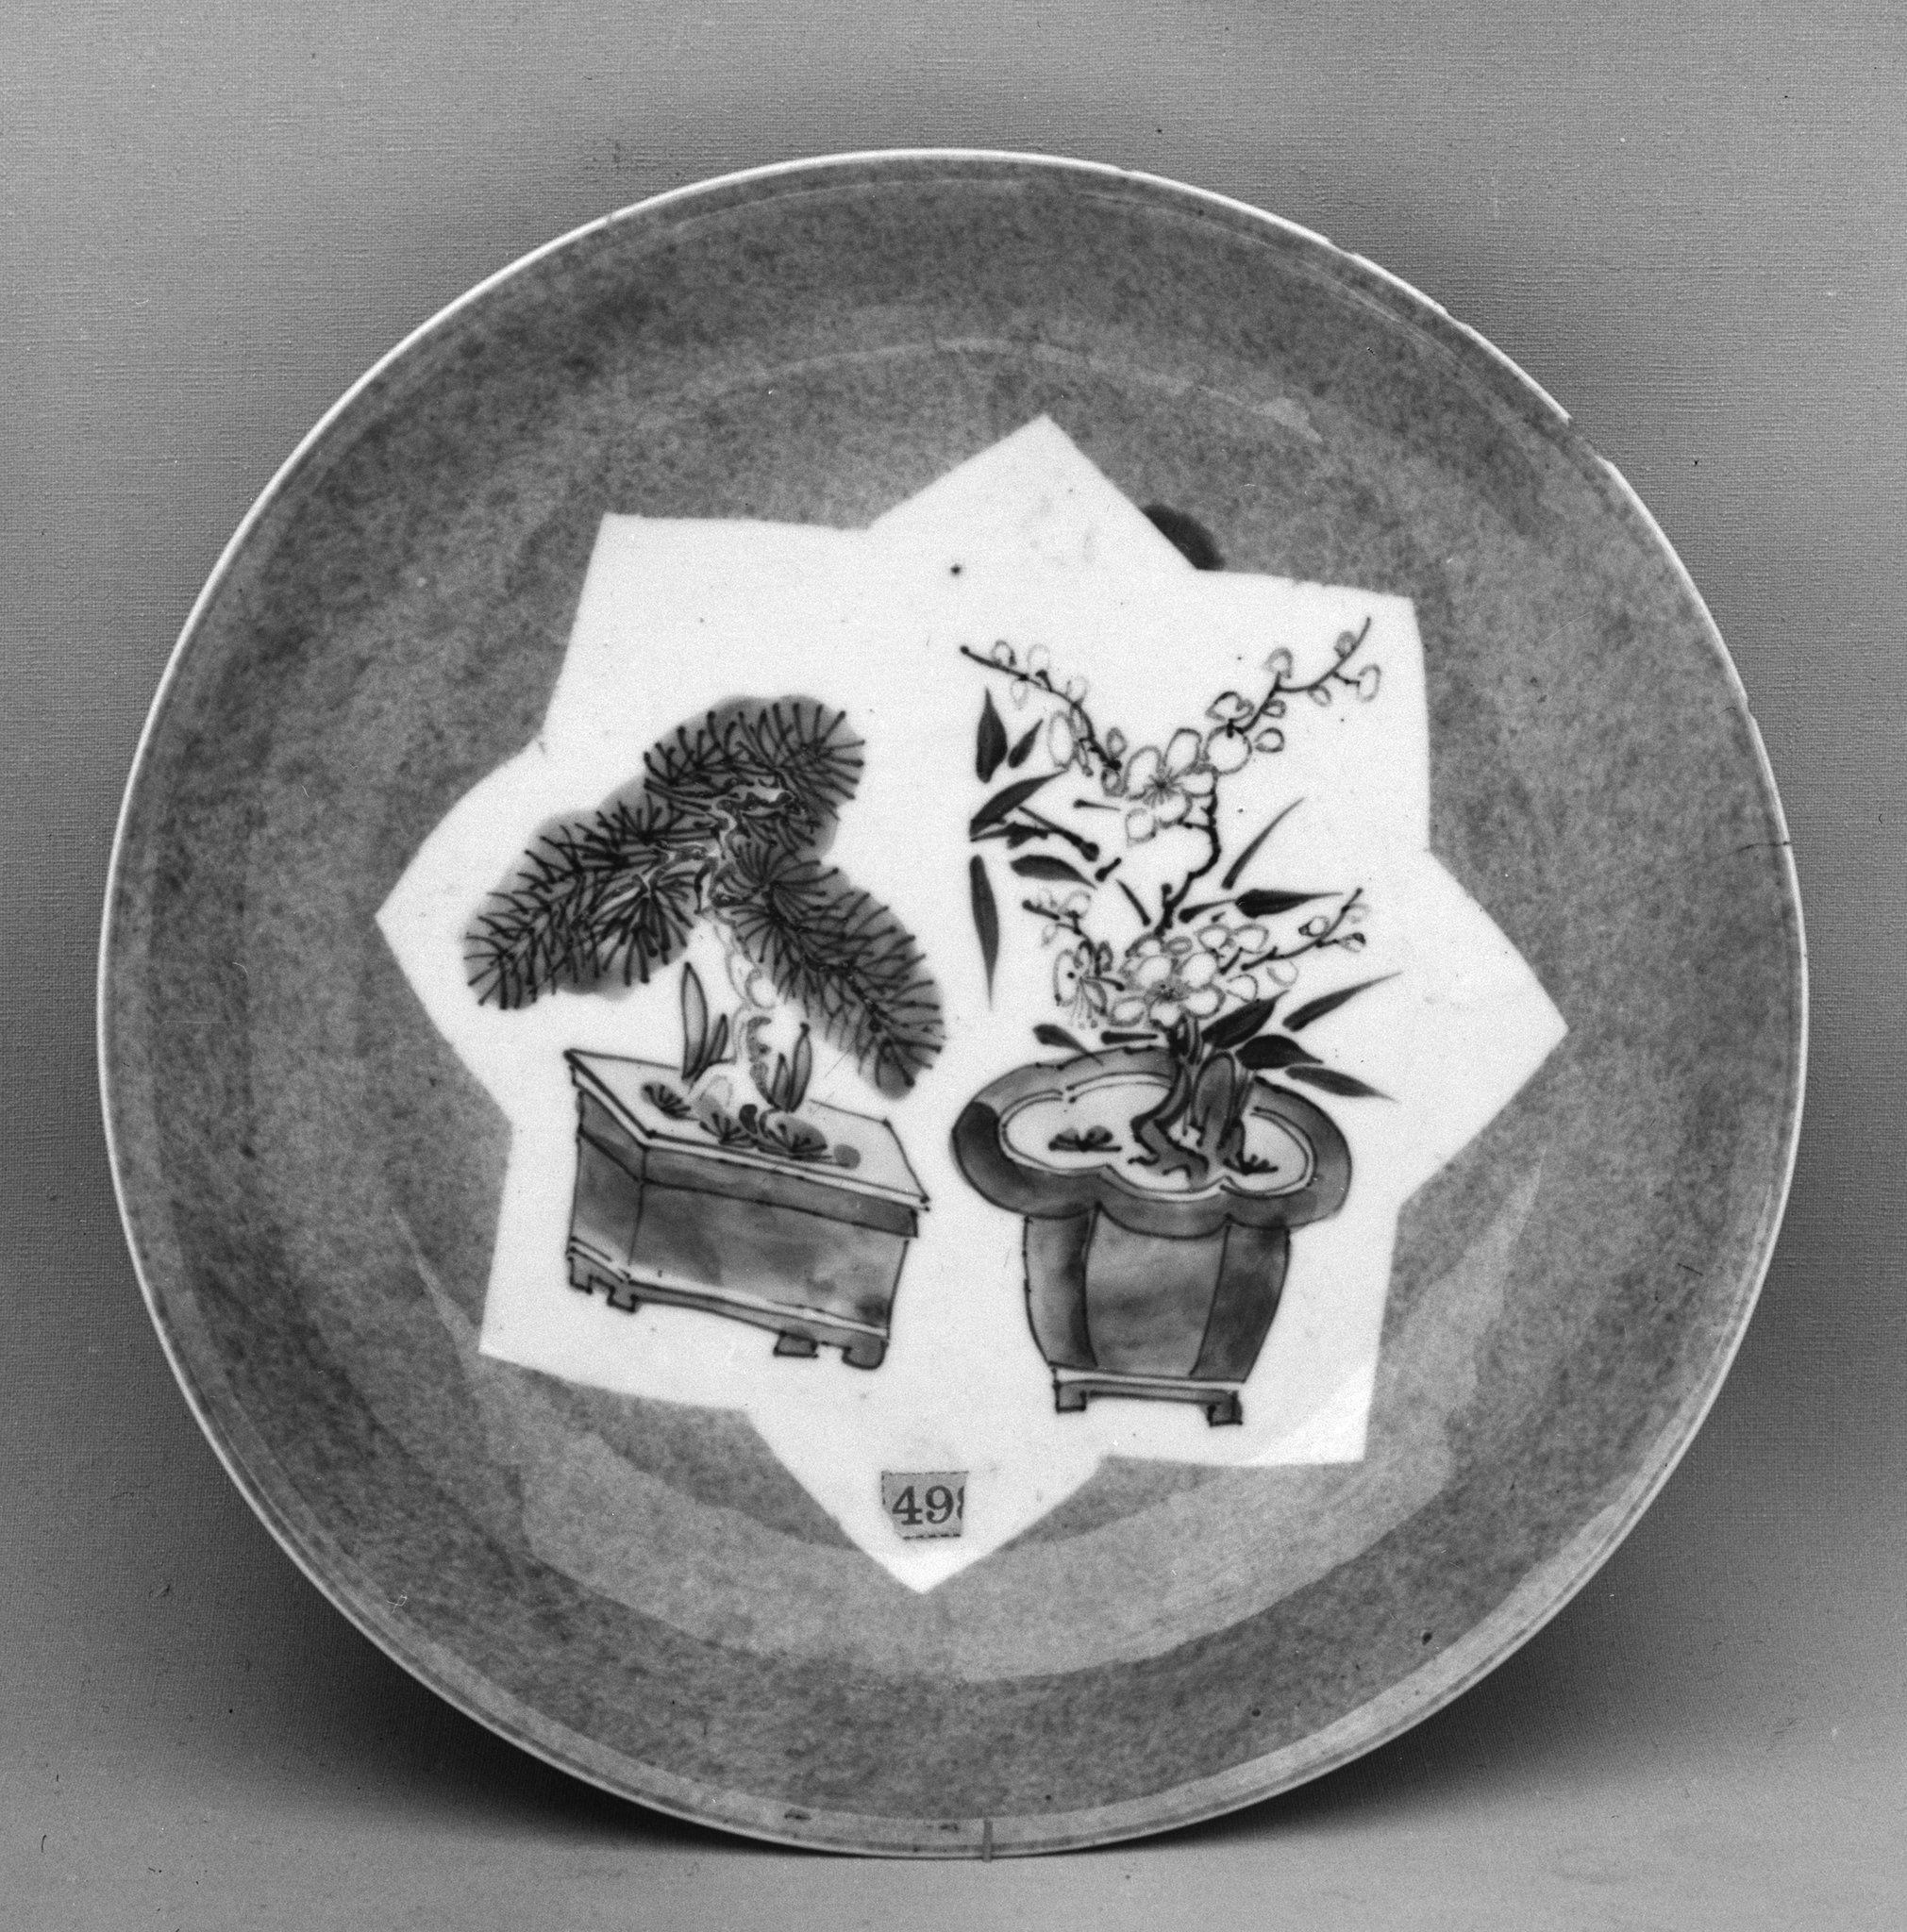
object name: dish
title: Dish with pine, plum blossom, and bamboo in planters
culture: chinese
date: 1667-1733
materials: cobalt, copper, porcelain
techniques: painting, underglaze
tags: plants